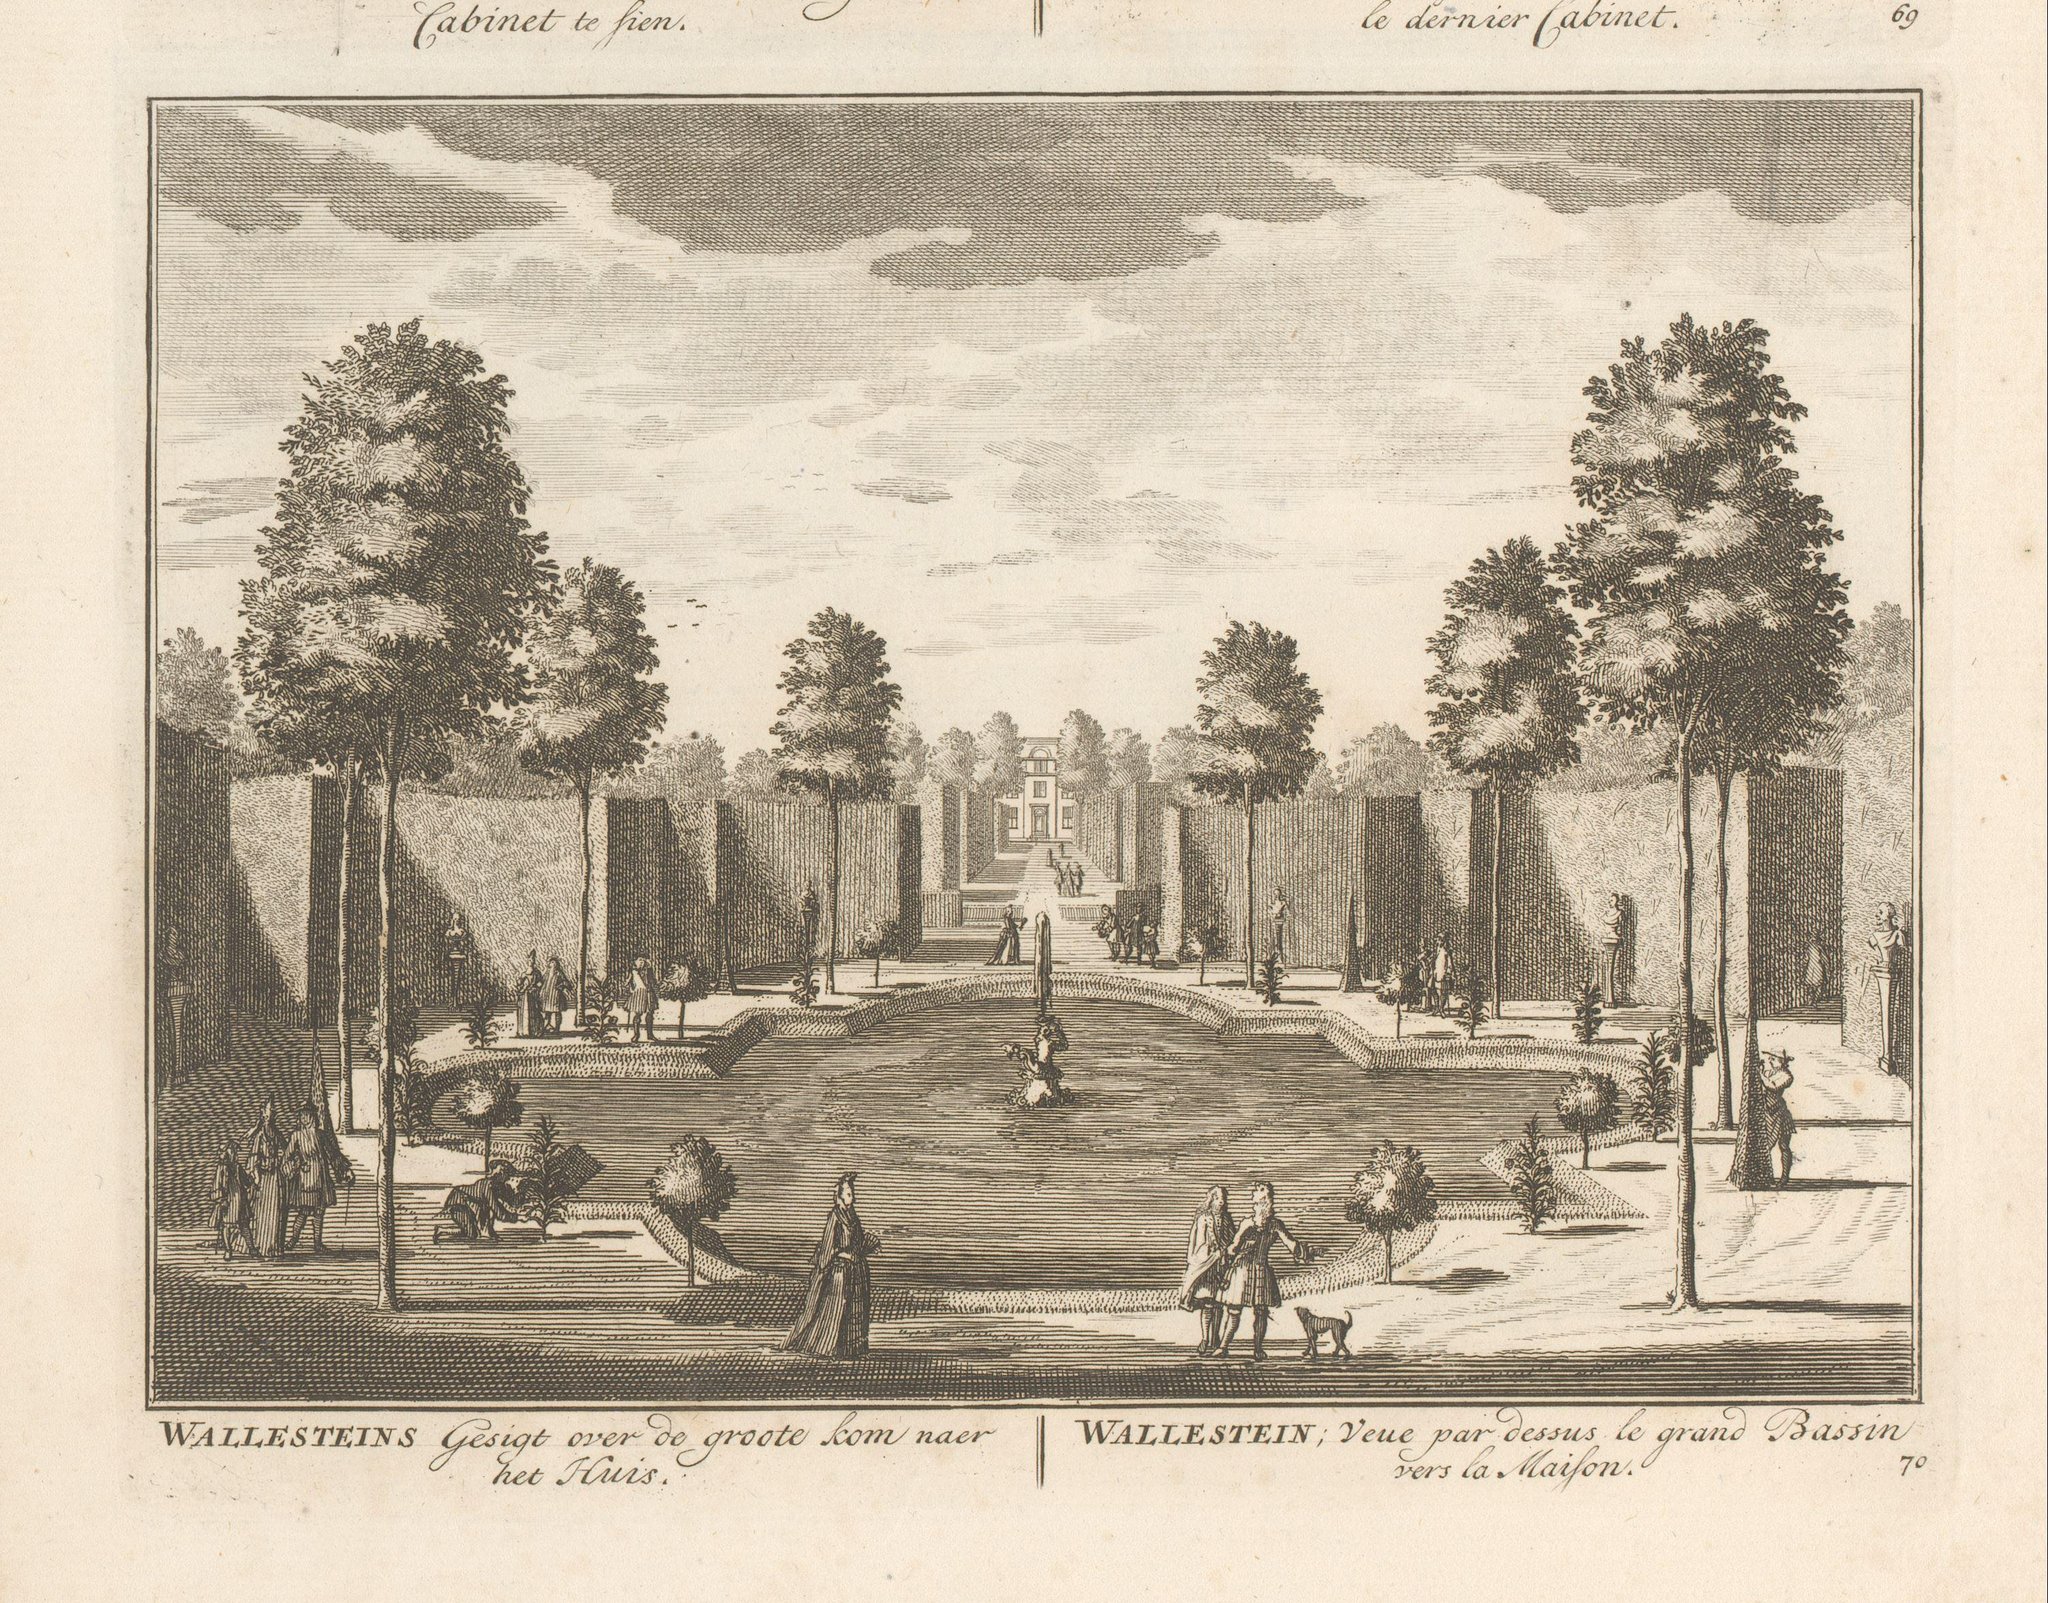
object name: album leaf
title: Wallesteins Gesigt over de groote kom naer het Huis / Wallestein; veue par dessus le grand Bassin vers la Maison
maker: daniël stopendaal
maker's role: print maker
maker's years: 1672-1726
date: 1790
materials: paper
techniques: engraving, etching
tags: french or architectonic garden; formal garden, country-house, vecht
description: Prent gebruikt in: Leth, Andries de. De zegepraalende Vecht, vertoonende verscheidene gesichten van lustplaatsen, heeren huysen en dorpen, beginnende van Uitrecht en met Muyden besluytende (...). Amsterdam: Weduwe Nicolaus Visscher, 1719. Prent ook gebruikt in: Brouërius van Nidek, Matthaeus. De Vechtstroom, van Utrecht tot Muiden (...). Amsterdam: H. Gartman, W. Vermandel en J.W. Smit, 1790.